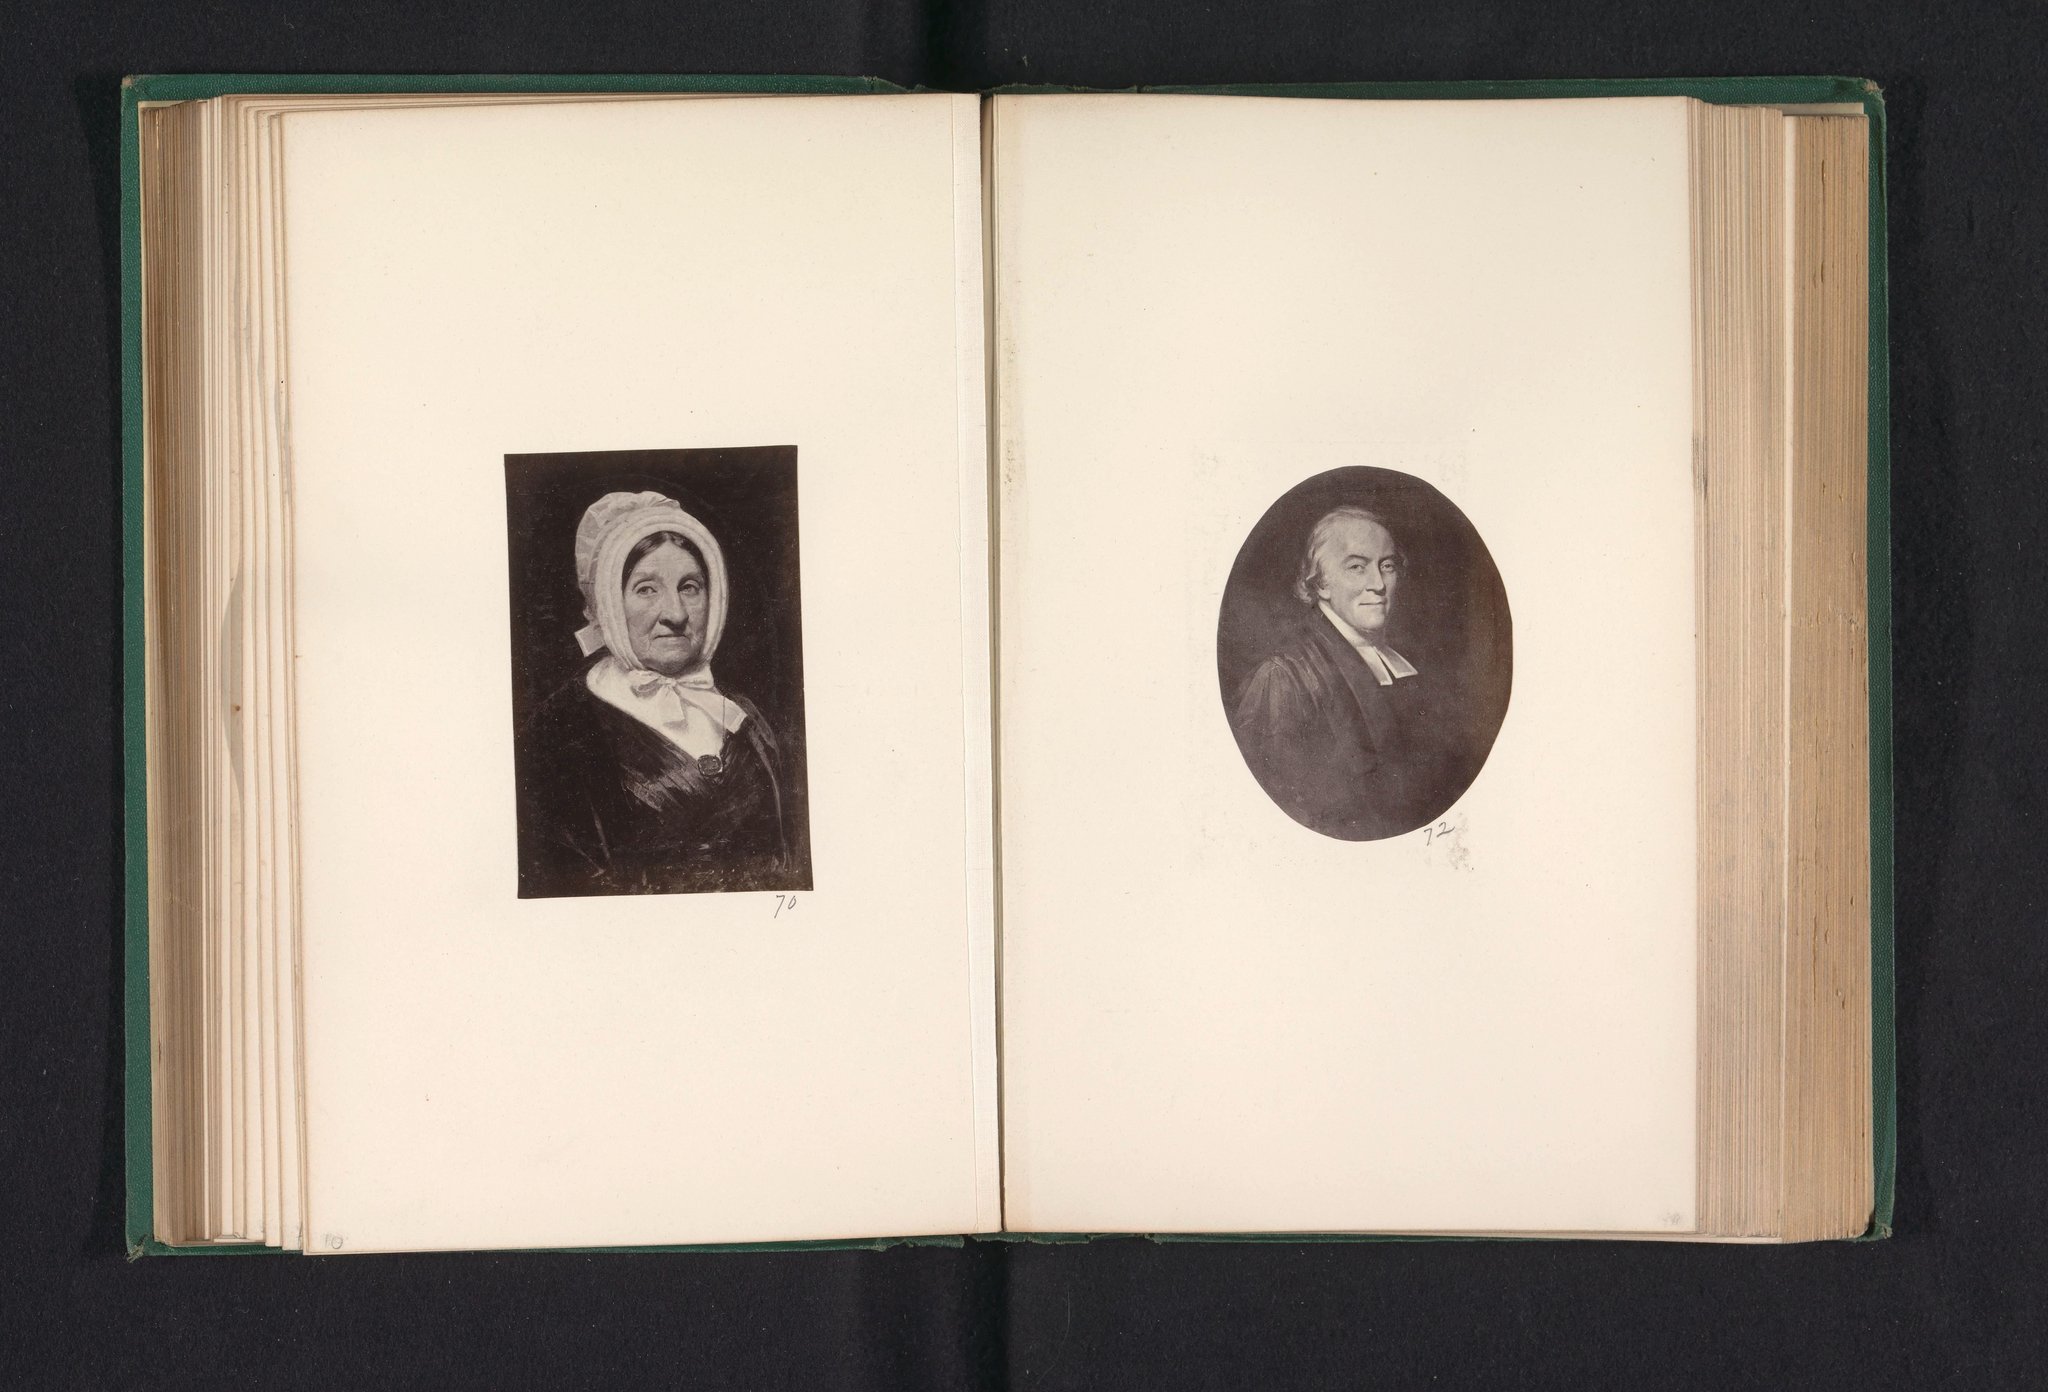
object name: page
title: Fotoreproductie van een schilderij, voorstellende een portret van Mrs. Baird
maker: thomas annan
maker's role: fotograaf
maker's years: 1829-1887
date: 1863-1868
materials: photographic support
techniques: albumen print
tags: historical persons (portraits and scenes from the life) - bb - woman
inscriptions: number: ‘70’